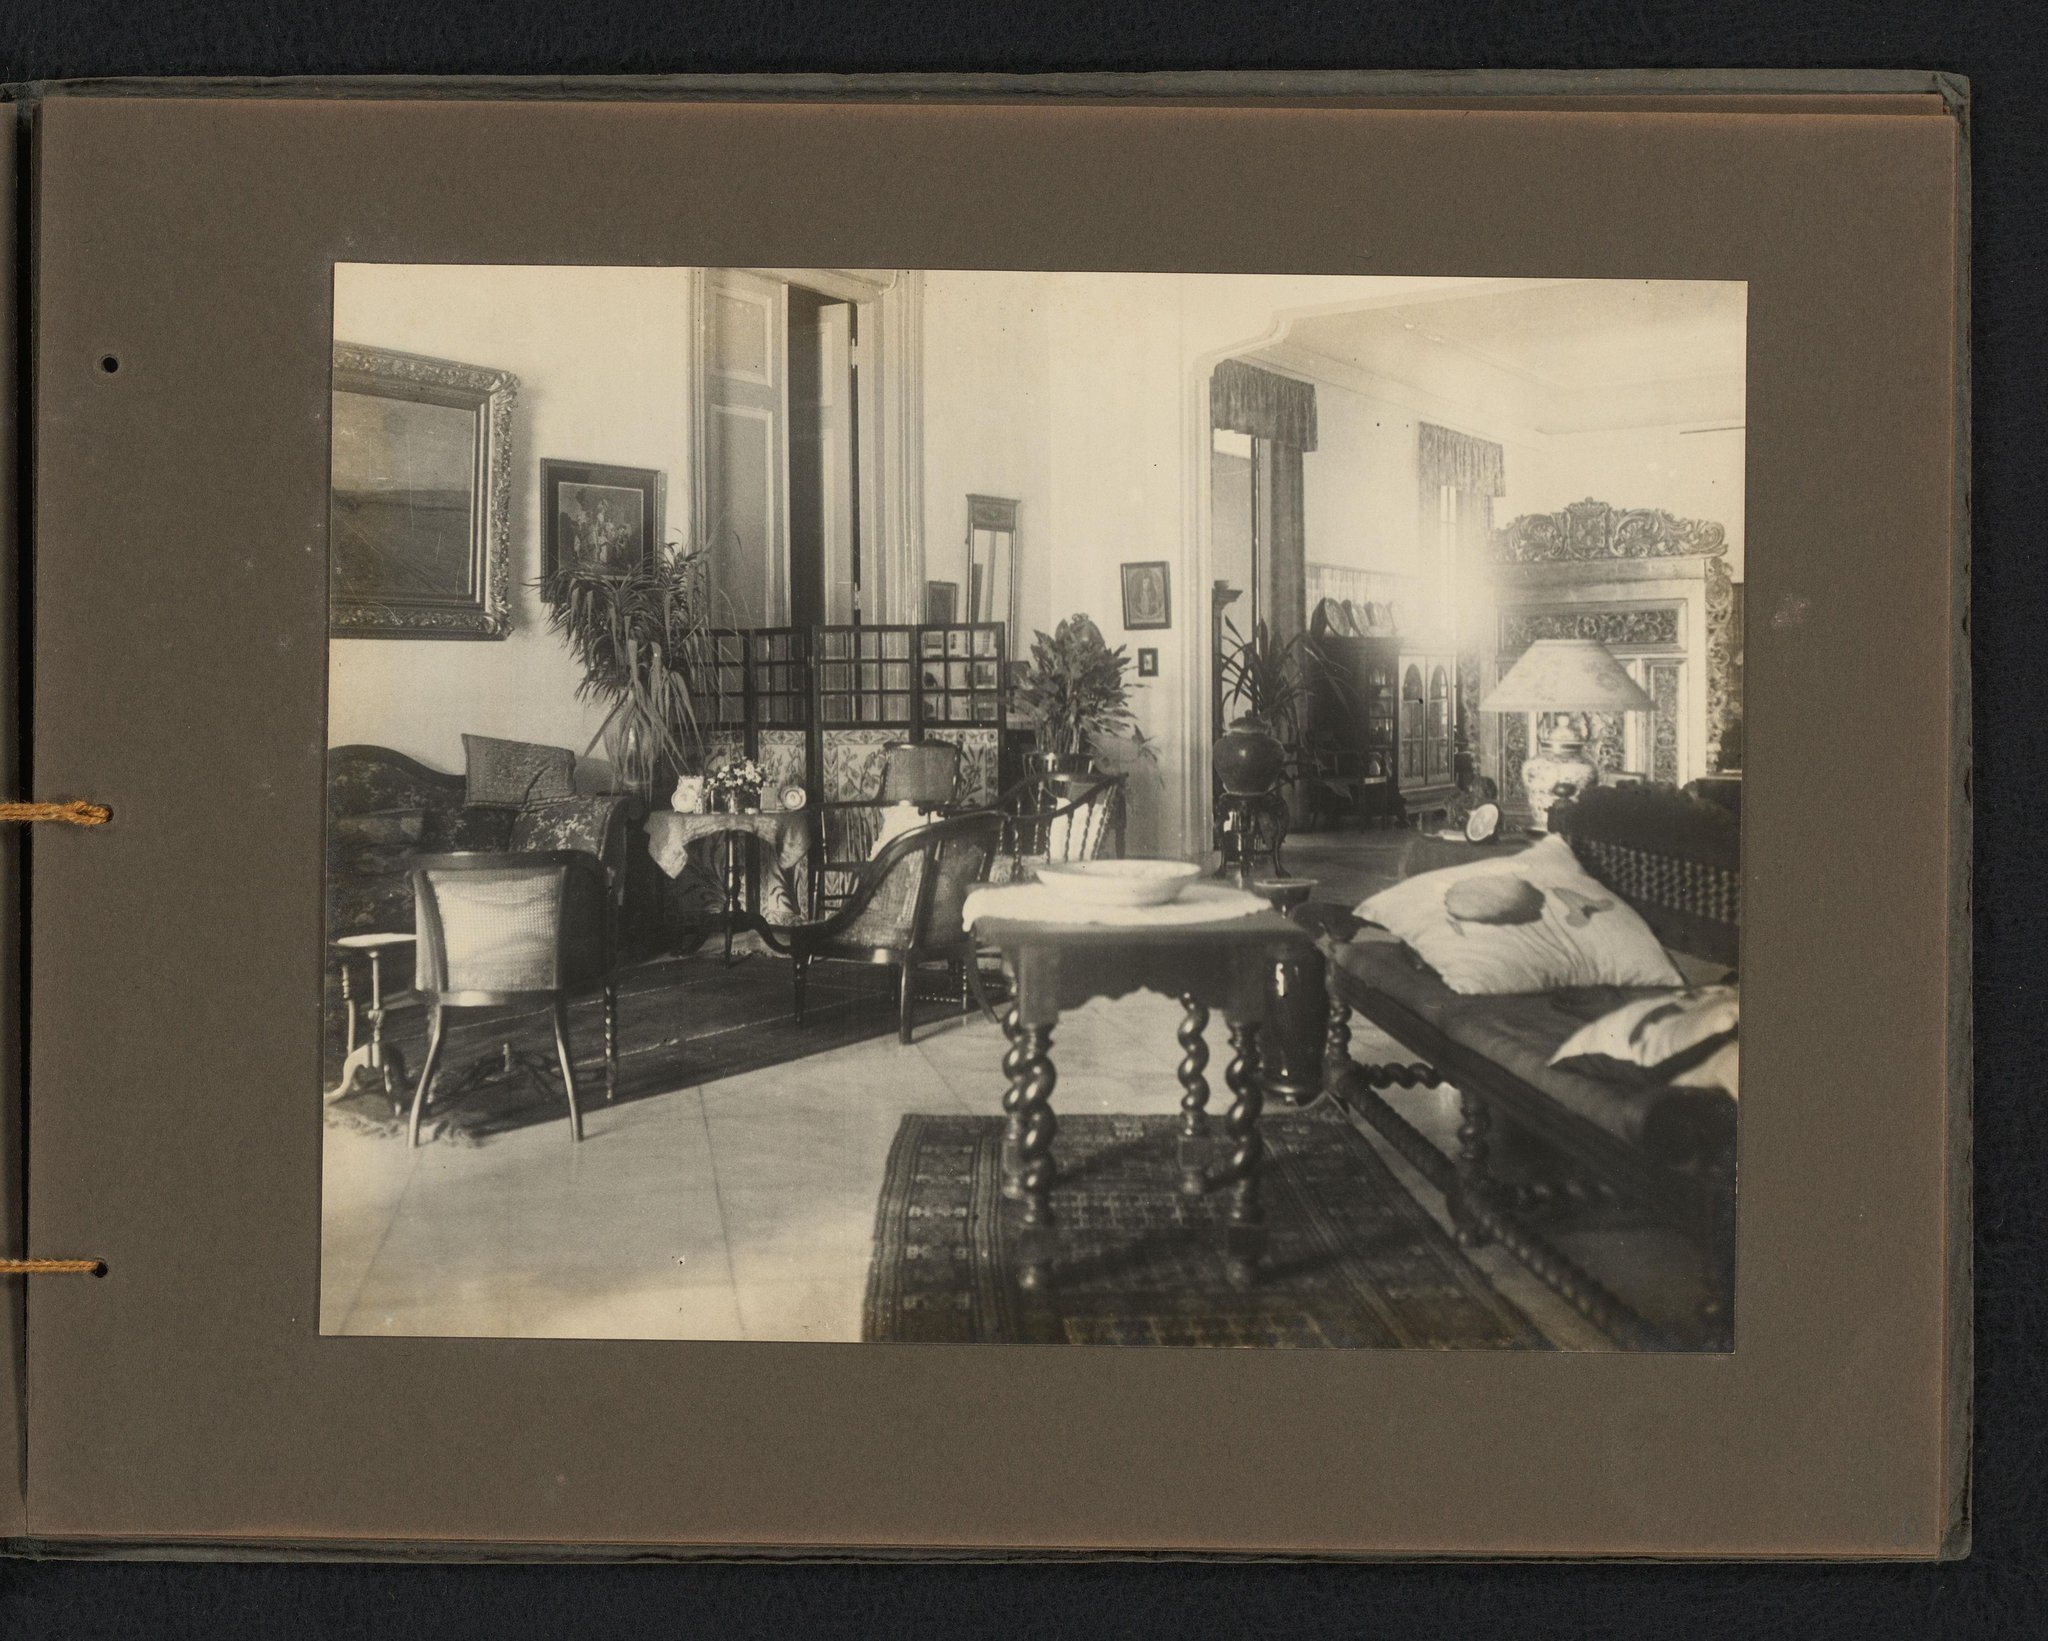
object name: photograph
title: Interieur van een ruimte met verschillende zithoeken in de ambtswoning van de Javasche Bank te Batavia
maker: Anonymous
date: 1921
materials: paper, cardboard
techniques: gelatin silver print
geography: batavia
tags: interior ~ representation of a building, living-room, parlour, sitting-room, batavia